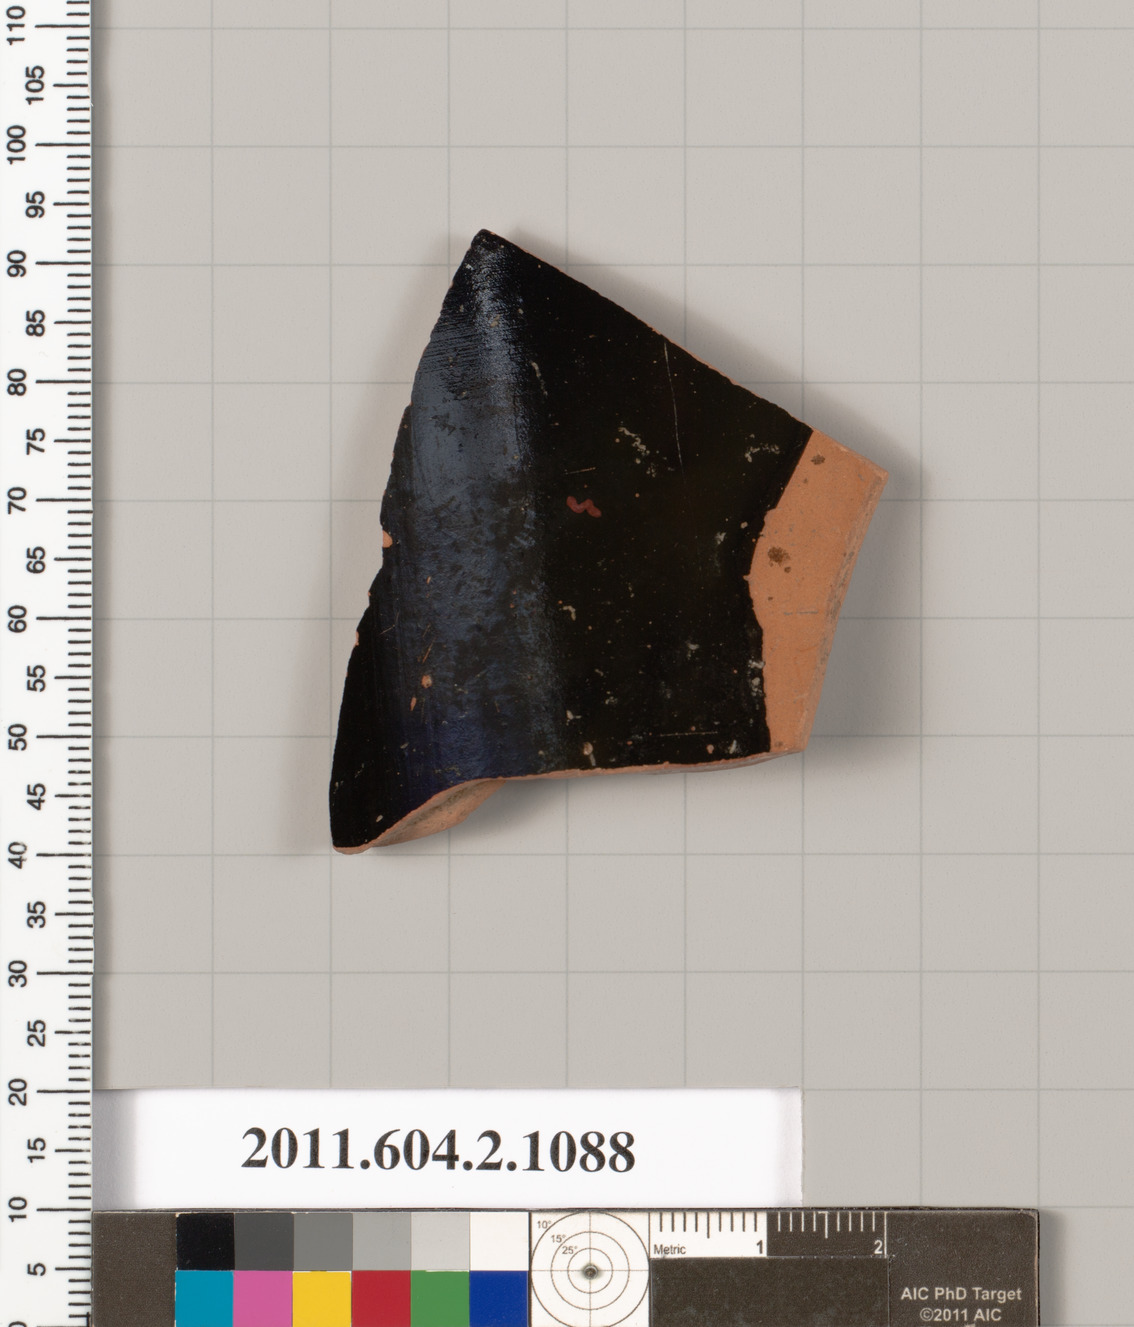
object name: lekythos fragment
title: Terracotta fragment of a lekythos (oil flask)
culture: greek, attic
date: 500-476 BCE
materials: terracotta